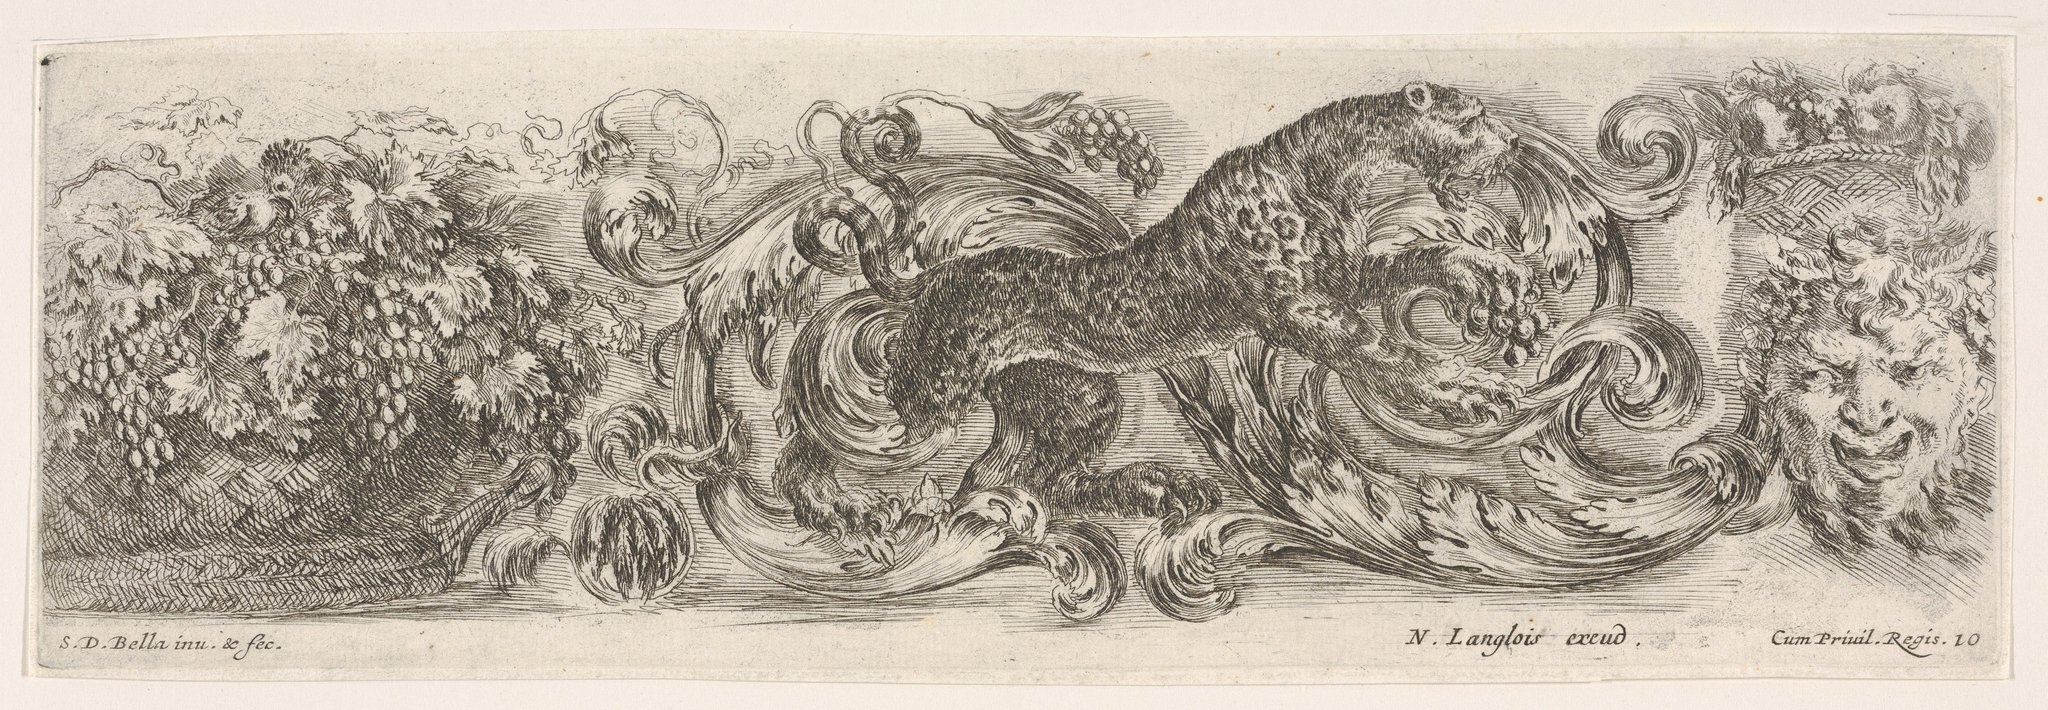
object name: print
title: Design for a Frieze with Acanthus Scrolls and a Leopard in the Center, plate 10 from "Decorative friezes and foliage" (Ornamenti di fregi e fogliami)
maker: stefano della bella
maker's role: artist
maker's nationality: italian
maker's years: 1610-1664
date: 1645-1650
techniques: etching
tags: leopards